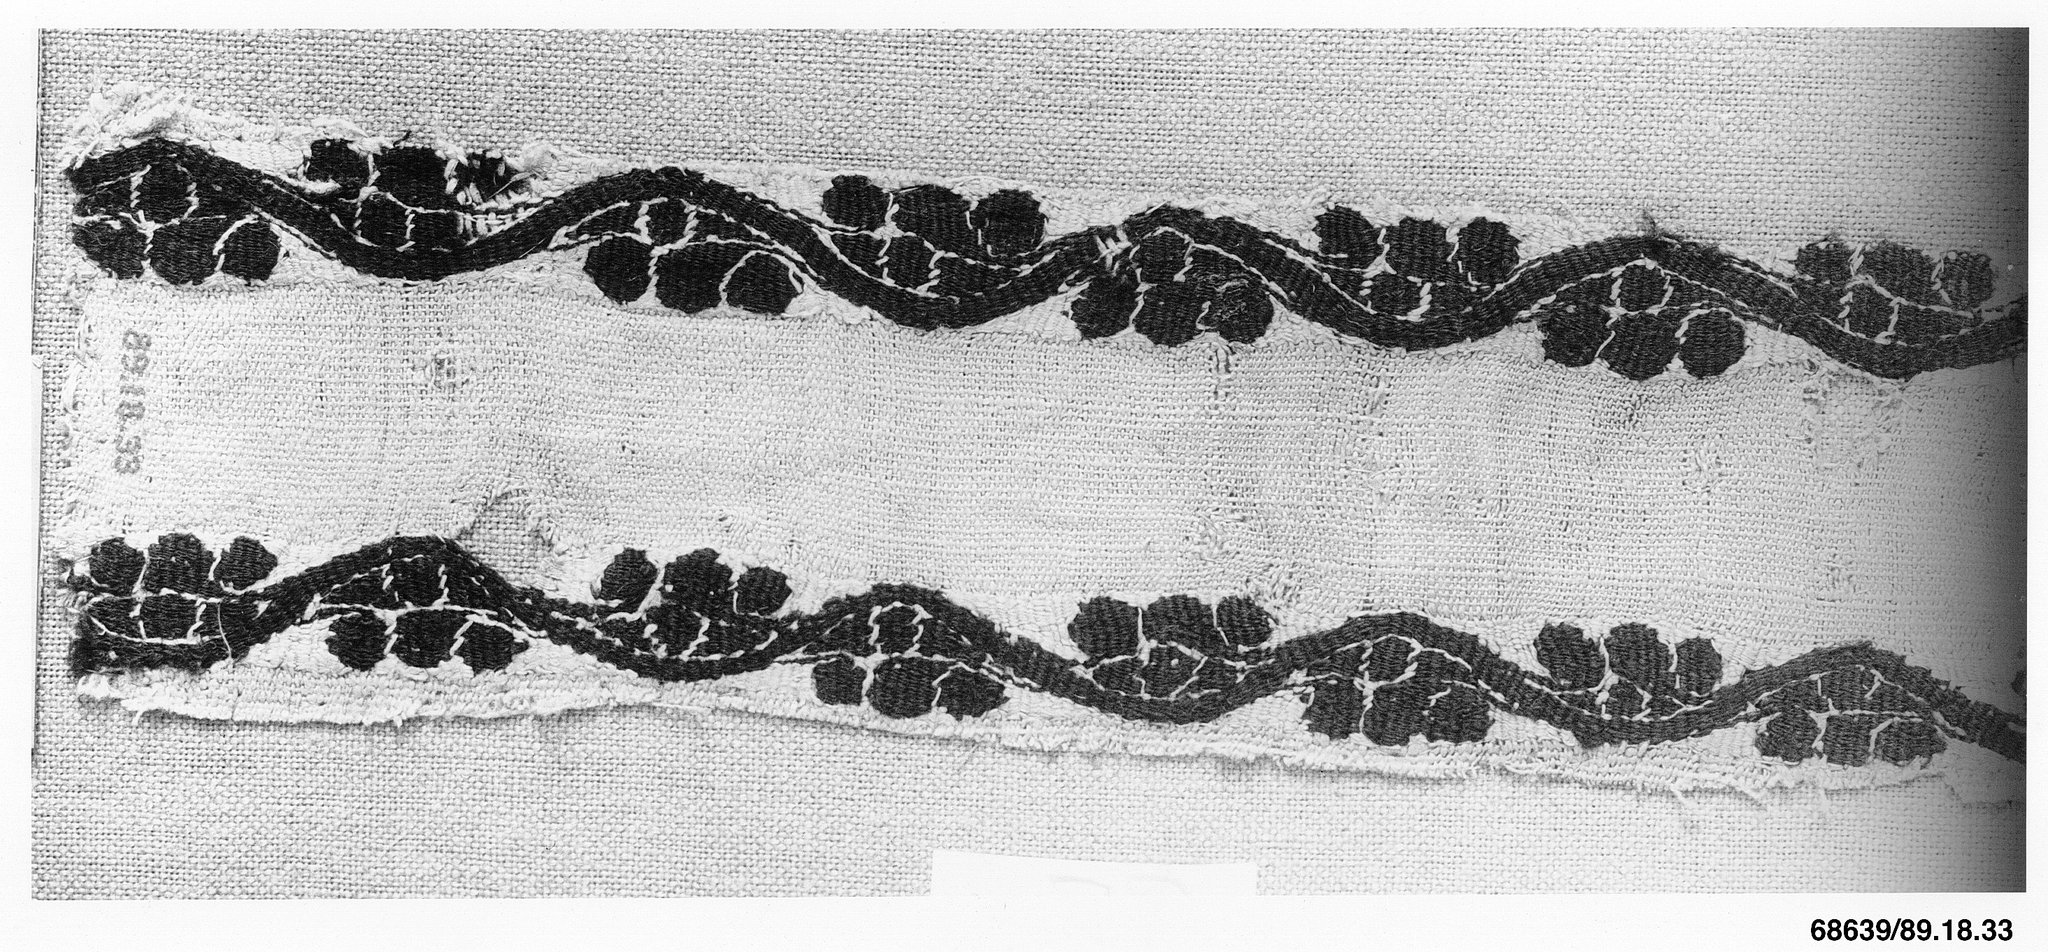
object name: textile fragment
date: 201-400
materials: linen, wool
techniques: weave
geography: egypt